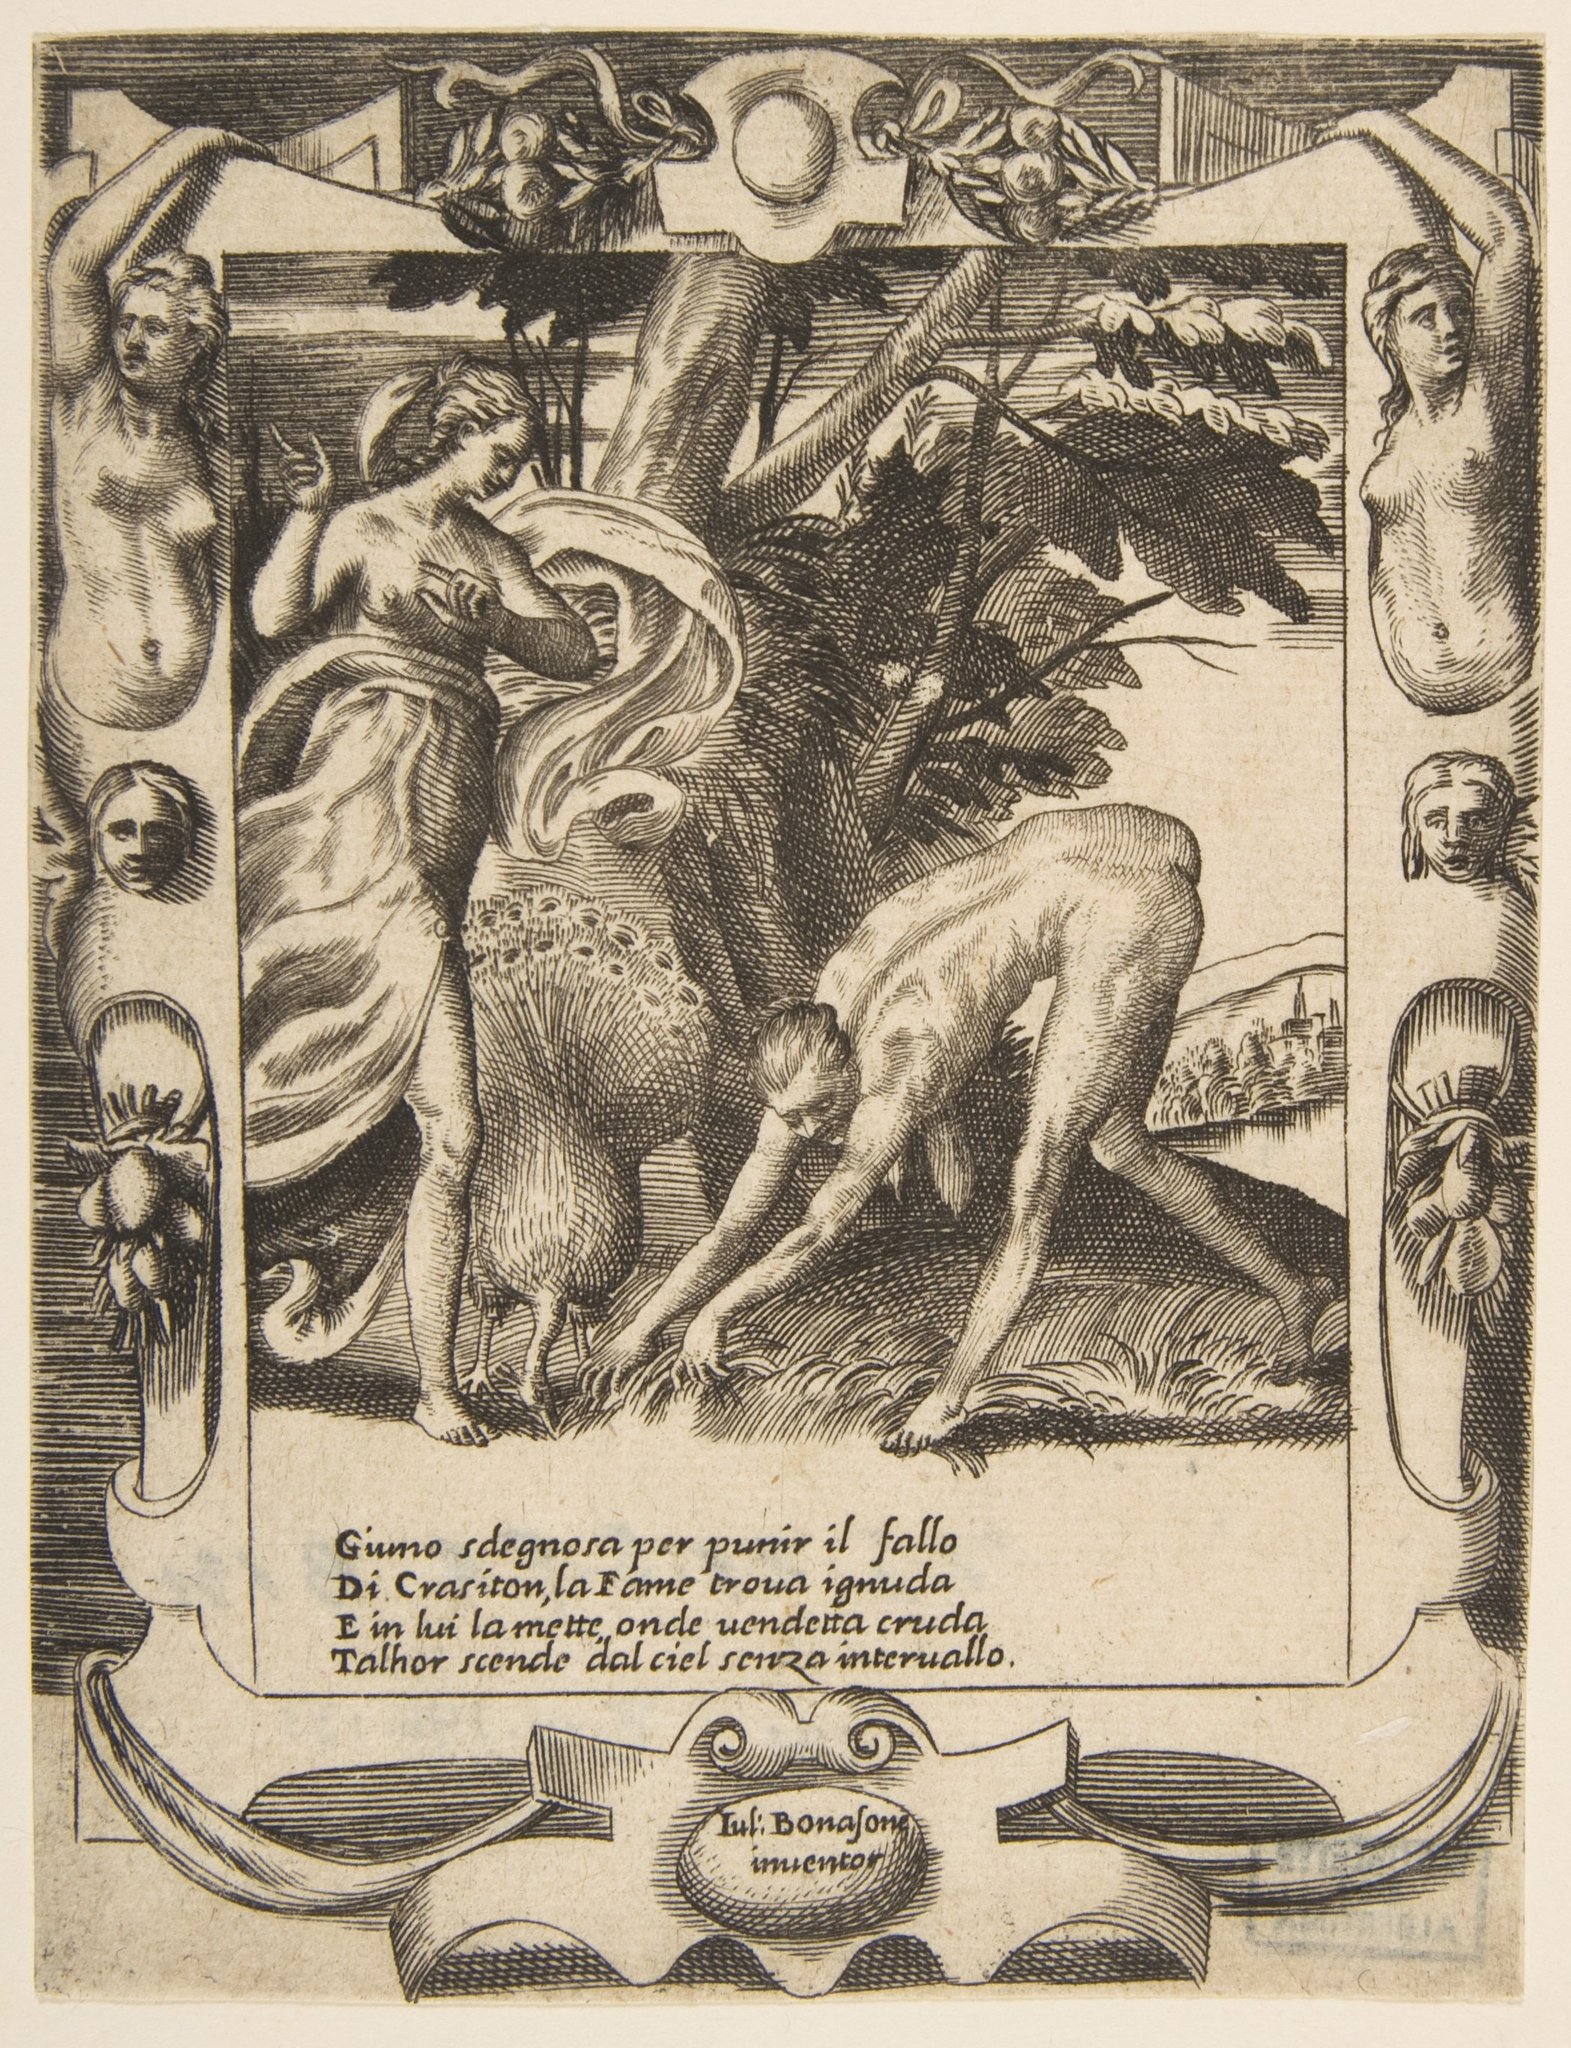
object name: print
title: Juno sending famine against Crasiton, set within an elaborate frame, from "Loves, Rages and Jealousies of Juno"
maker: giulio bonasone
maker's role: artist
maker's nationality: italian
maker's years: 1510-1576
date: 1531-1576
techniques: engraving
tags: female nudes,juno,peacocks